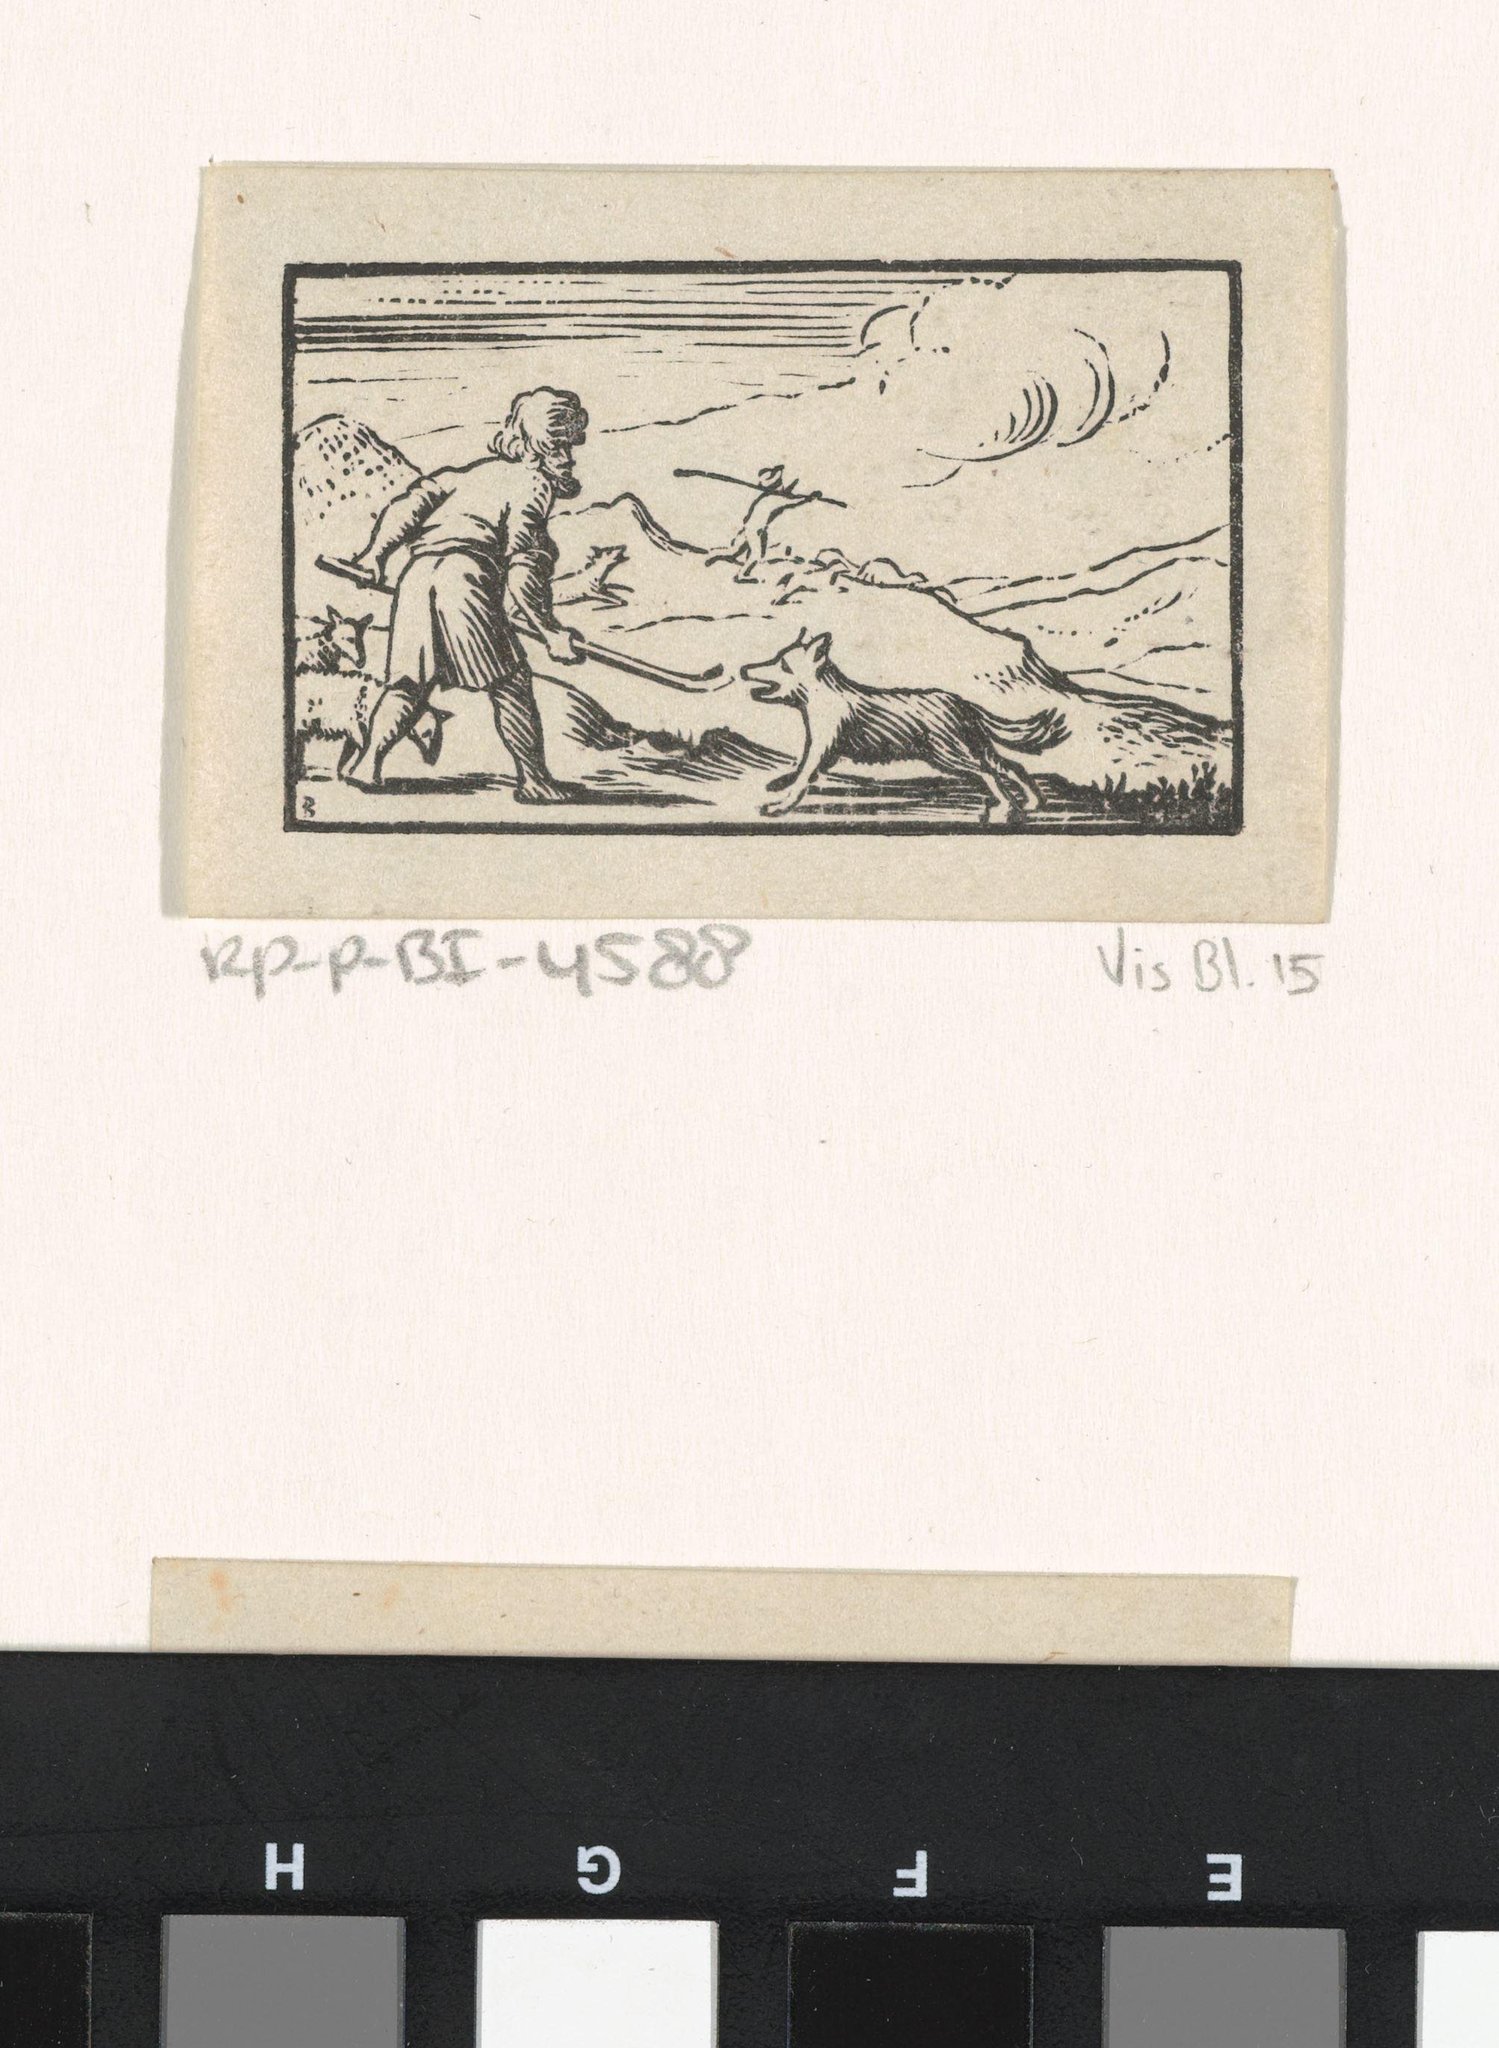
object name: print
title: Gelijkenis van Christus als de goede herder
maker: dirck de bray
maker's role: draughtsman, painter, print maker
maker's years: 1625-1694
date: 1635-1694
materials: paper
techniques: woodcut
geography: netherlands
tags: the good shepherd (christ) defending his sheep against wolves; 'i am the good shepherd' (john 10:1-16)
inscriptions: collector's mark: Lugt 240